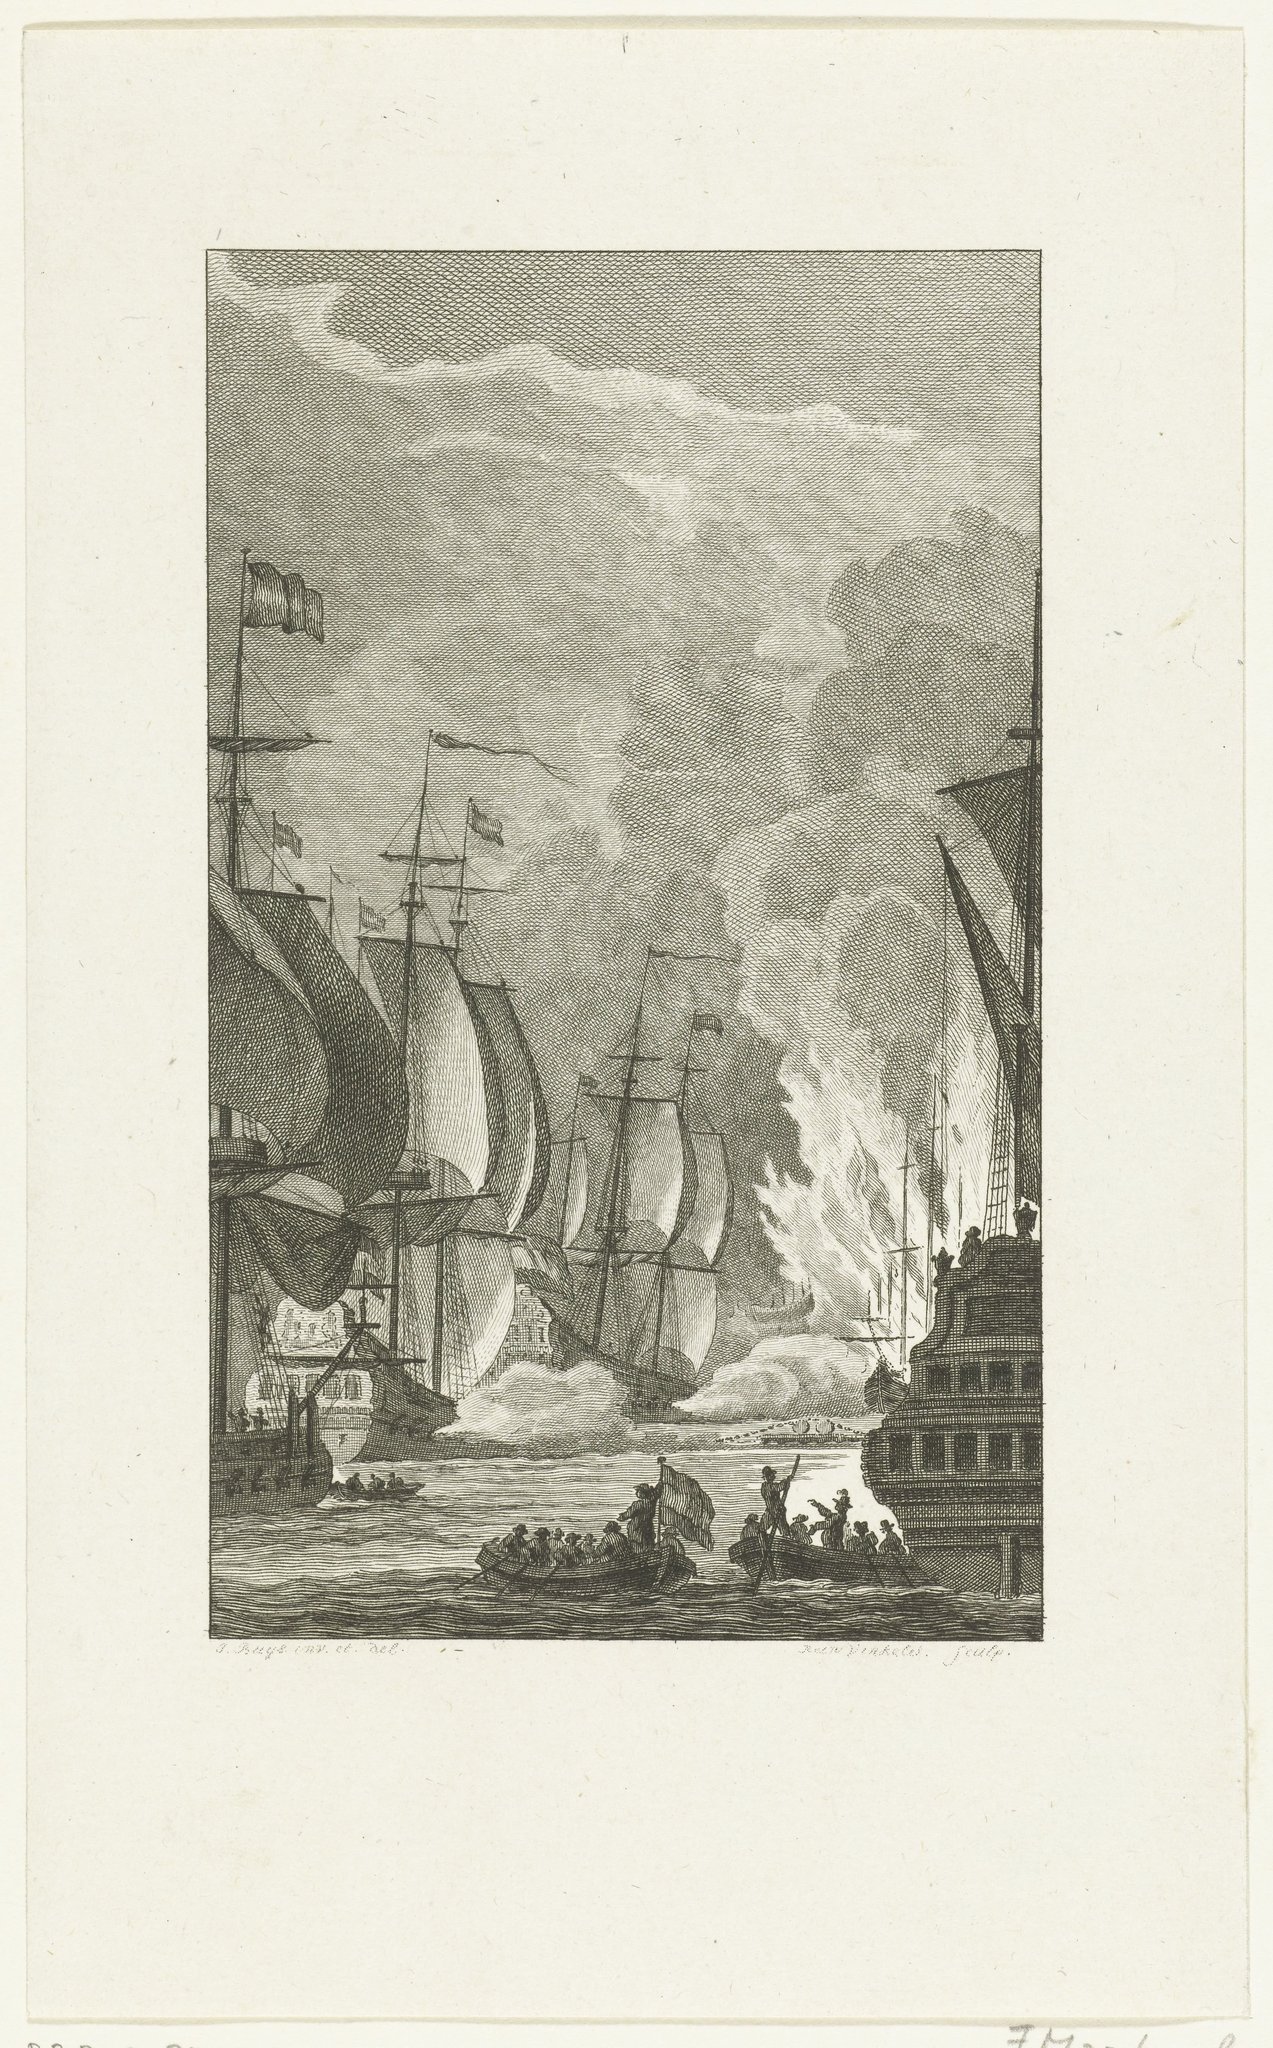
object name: history print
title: Het overvaren van de ketting in de Medway, 1667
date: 1788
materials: paper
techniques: etching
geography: netherlands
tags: battle (+ naval force), raid on the medway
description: Het overvaren van de ketting in de Medway door kapitein Jan van Brakel met zijn schip de Vreede en de branders Suzanna en Pro Patria, 22 juni 1667. Episode uit de Tocht naar Chatham en de vernietiging van de Engelse vloot op 20-23 juni 1667 door de Staatse vloot onder De Ruyter.